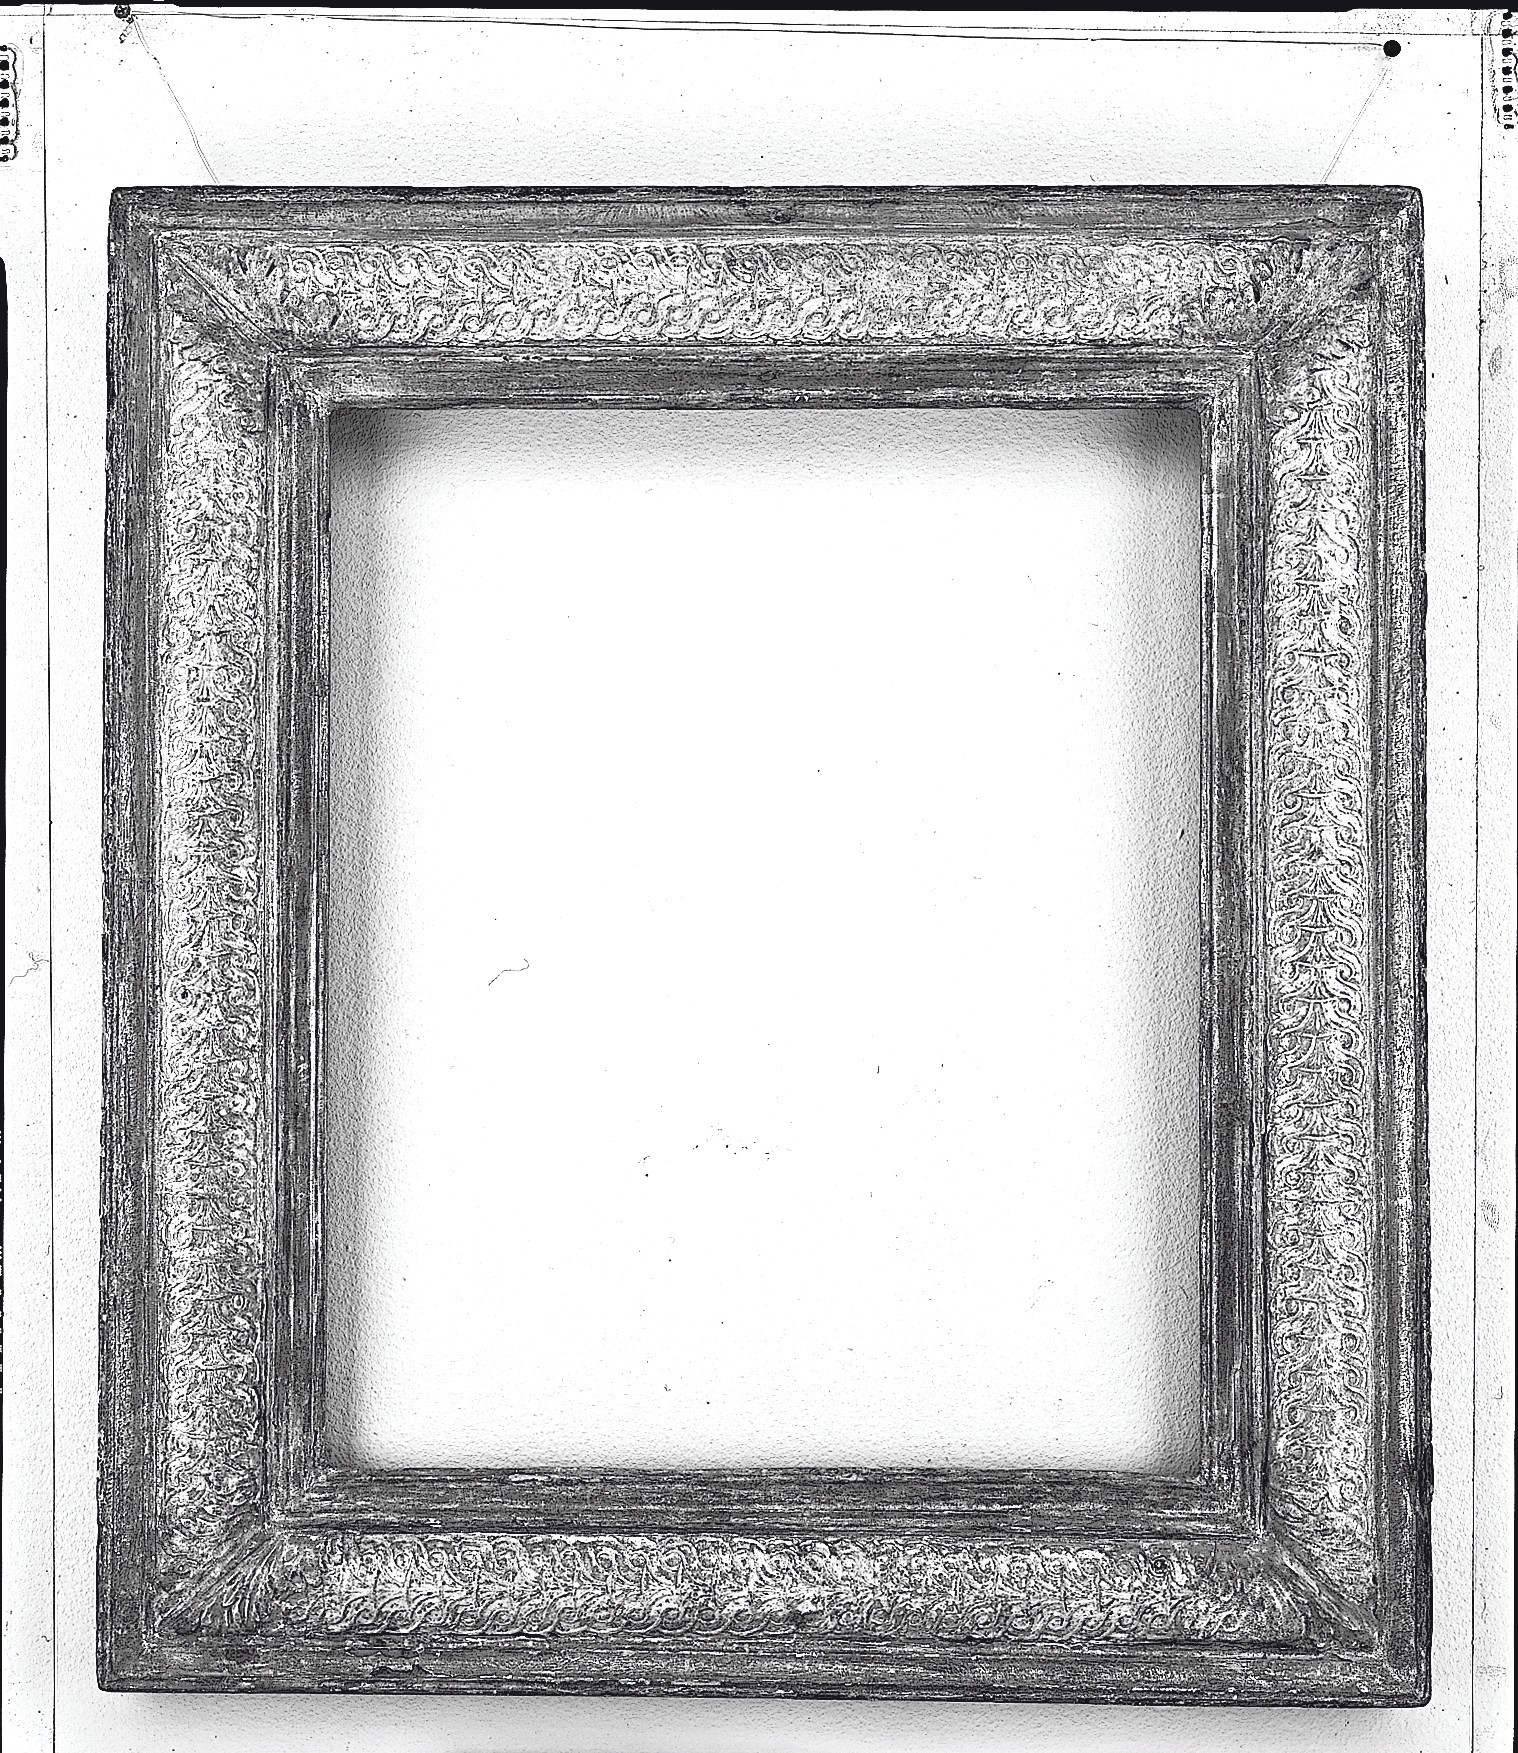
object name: frame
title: Cassetta frame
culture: italian, veneto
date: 1534-1566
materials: wood